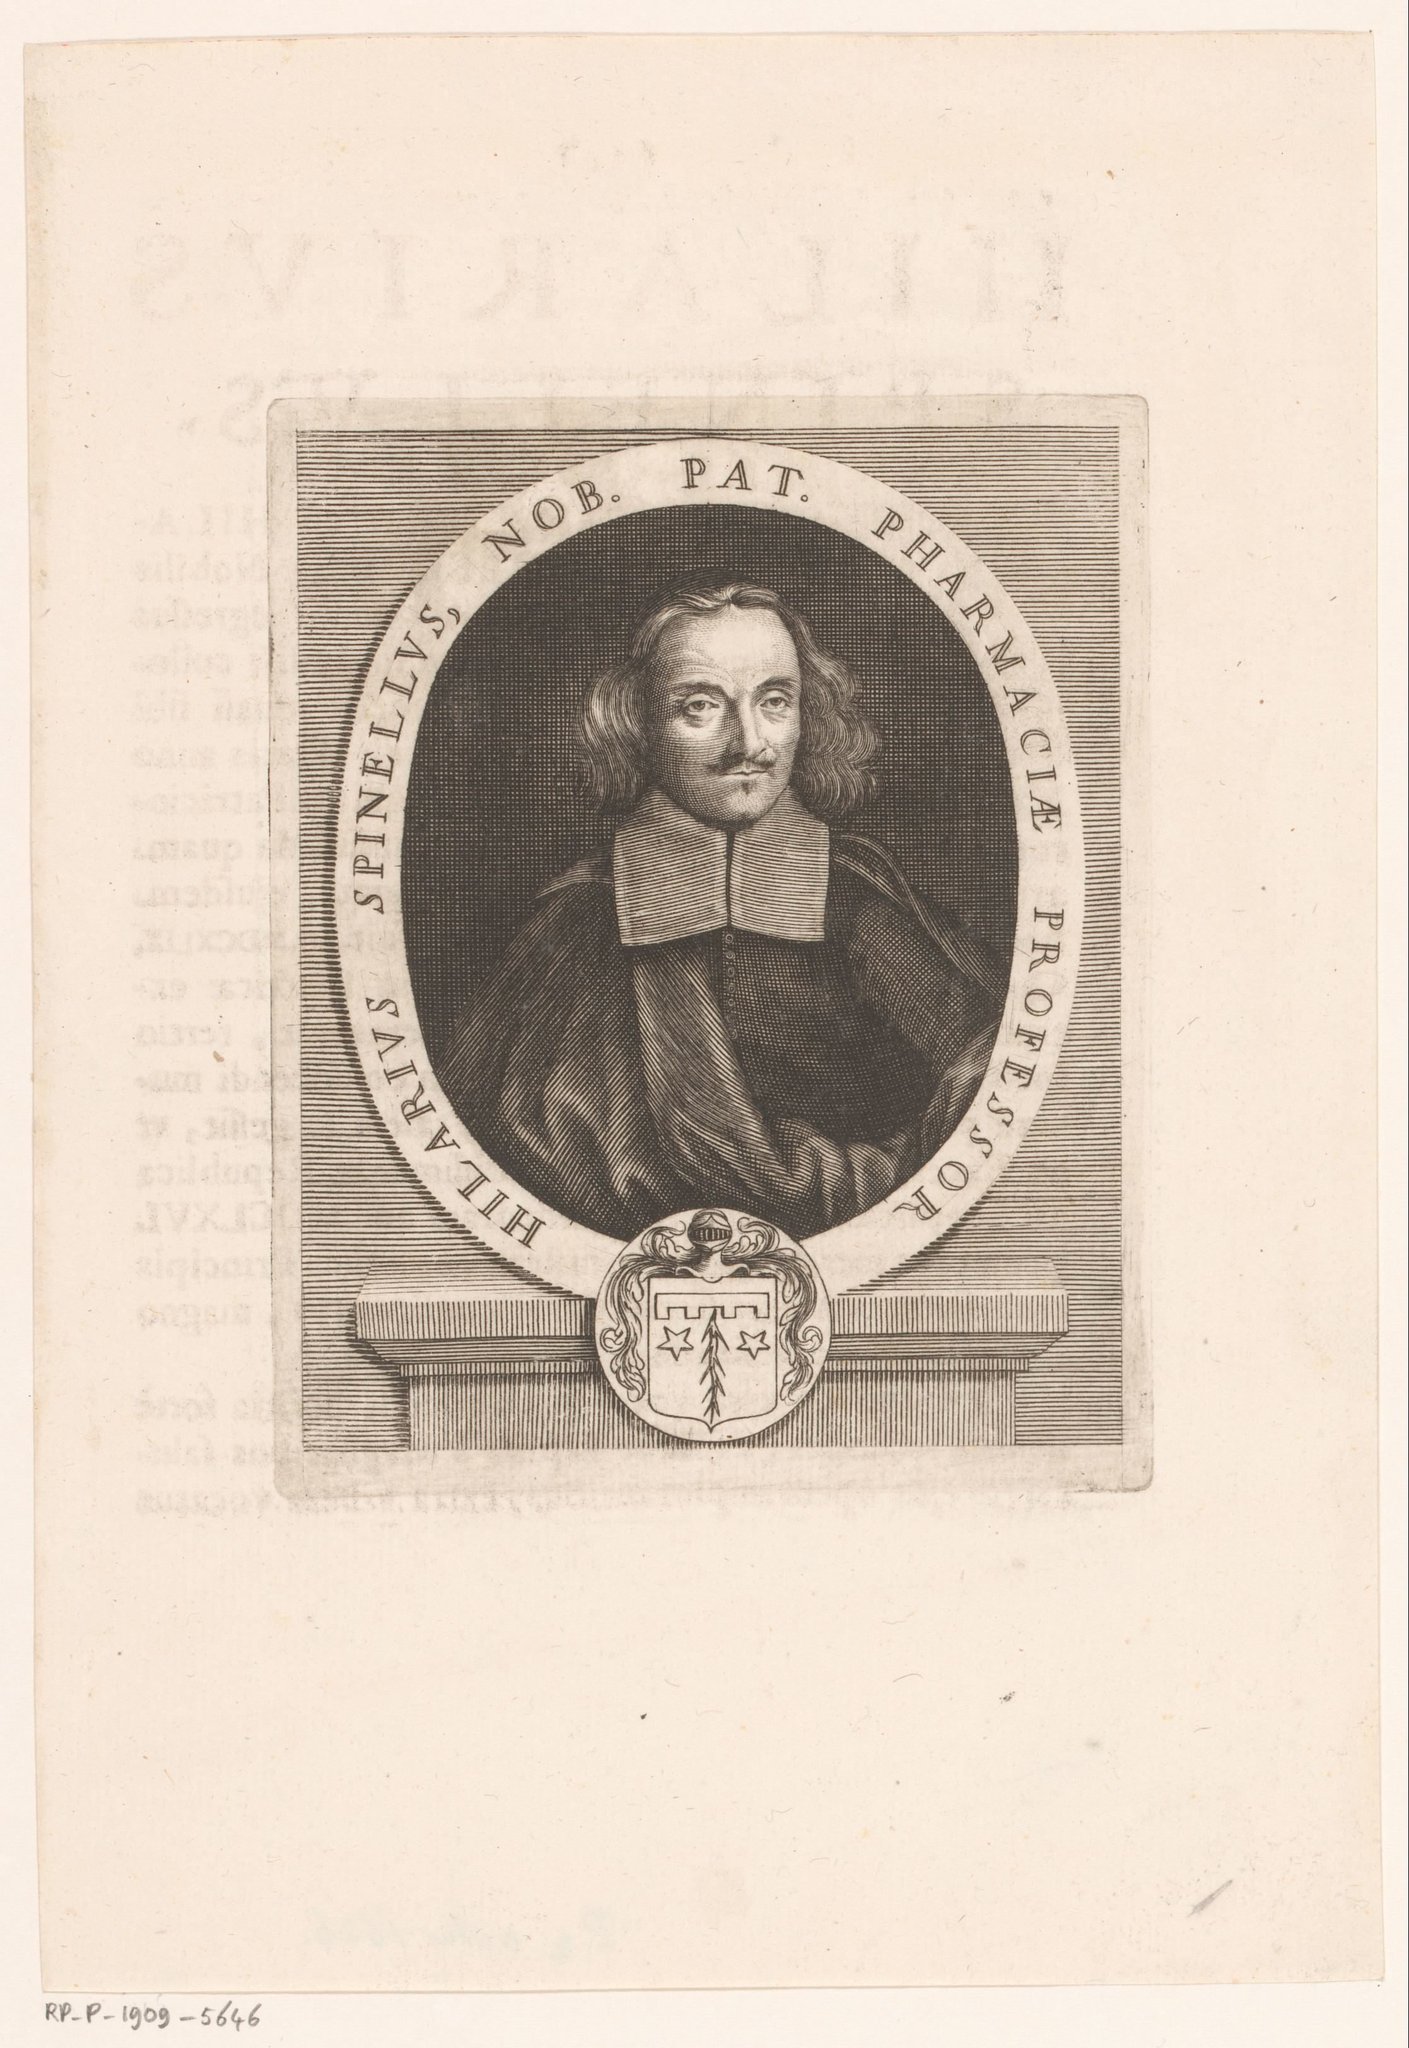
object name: book illustration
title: Portret van Hilarius Spinelius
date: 1682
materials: paper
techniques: engraving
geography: padua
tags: historical persons, professor, armorial bearing, heraldry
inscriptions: collector's mark: Lugt 2228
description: Prent uit: Patin, Charles. Lyceum Patavinum: sive icones et vitae professorum. Padua: Frambotti, Petri Mariae, 1682.